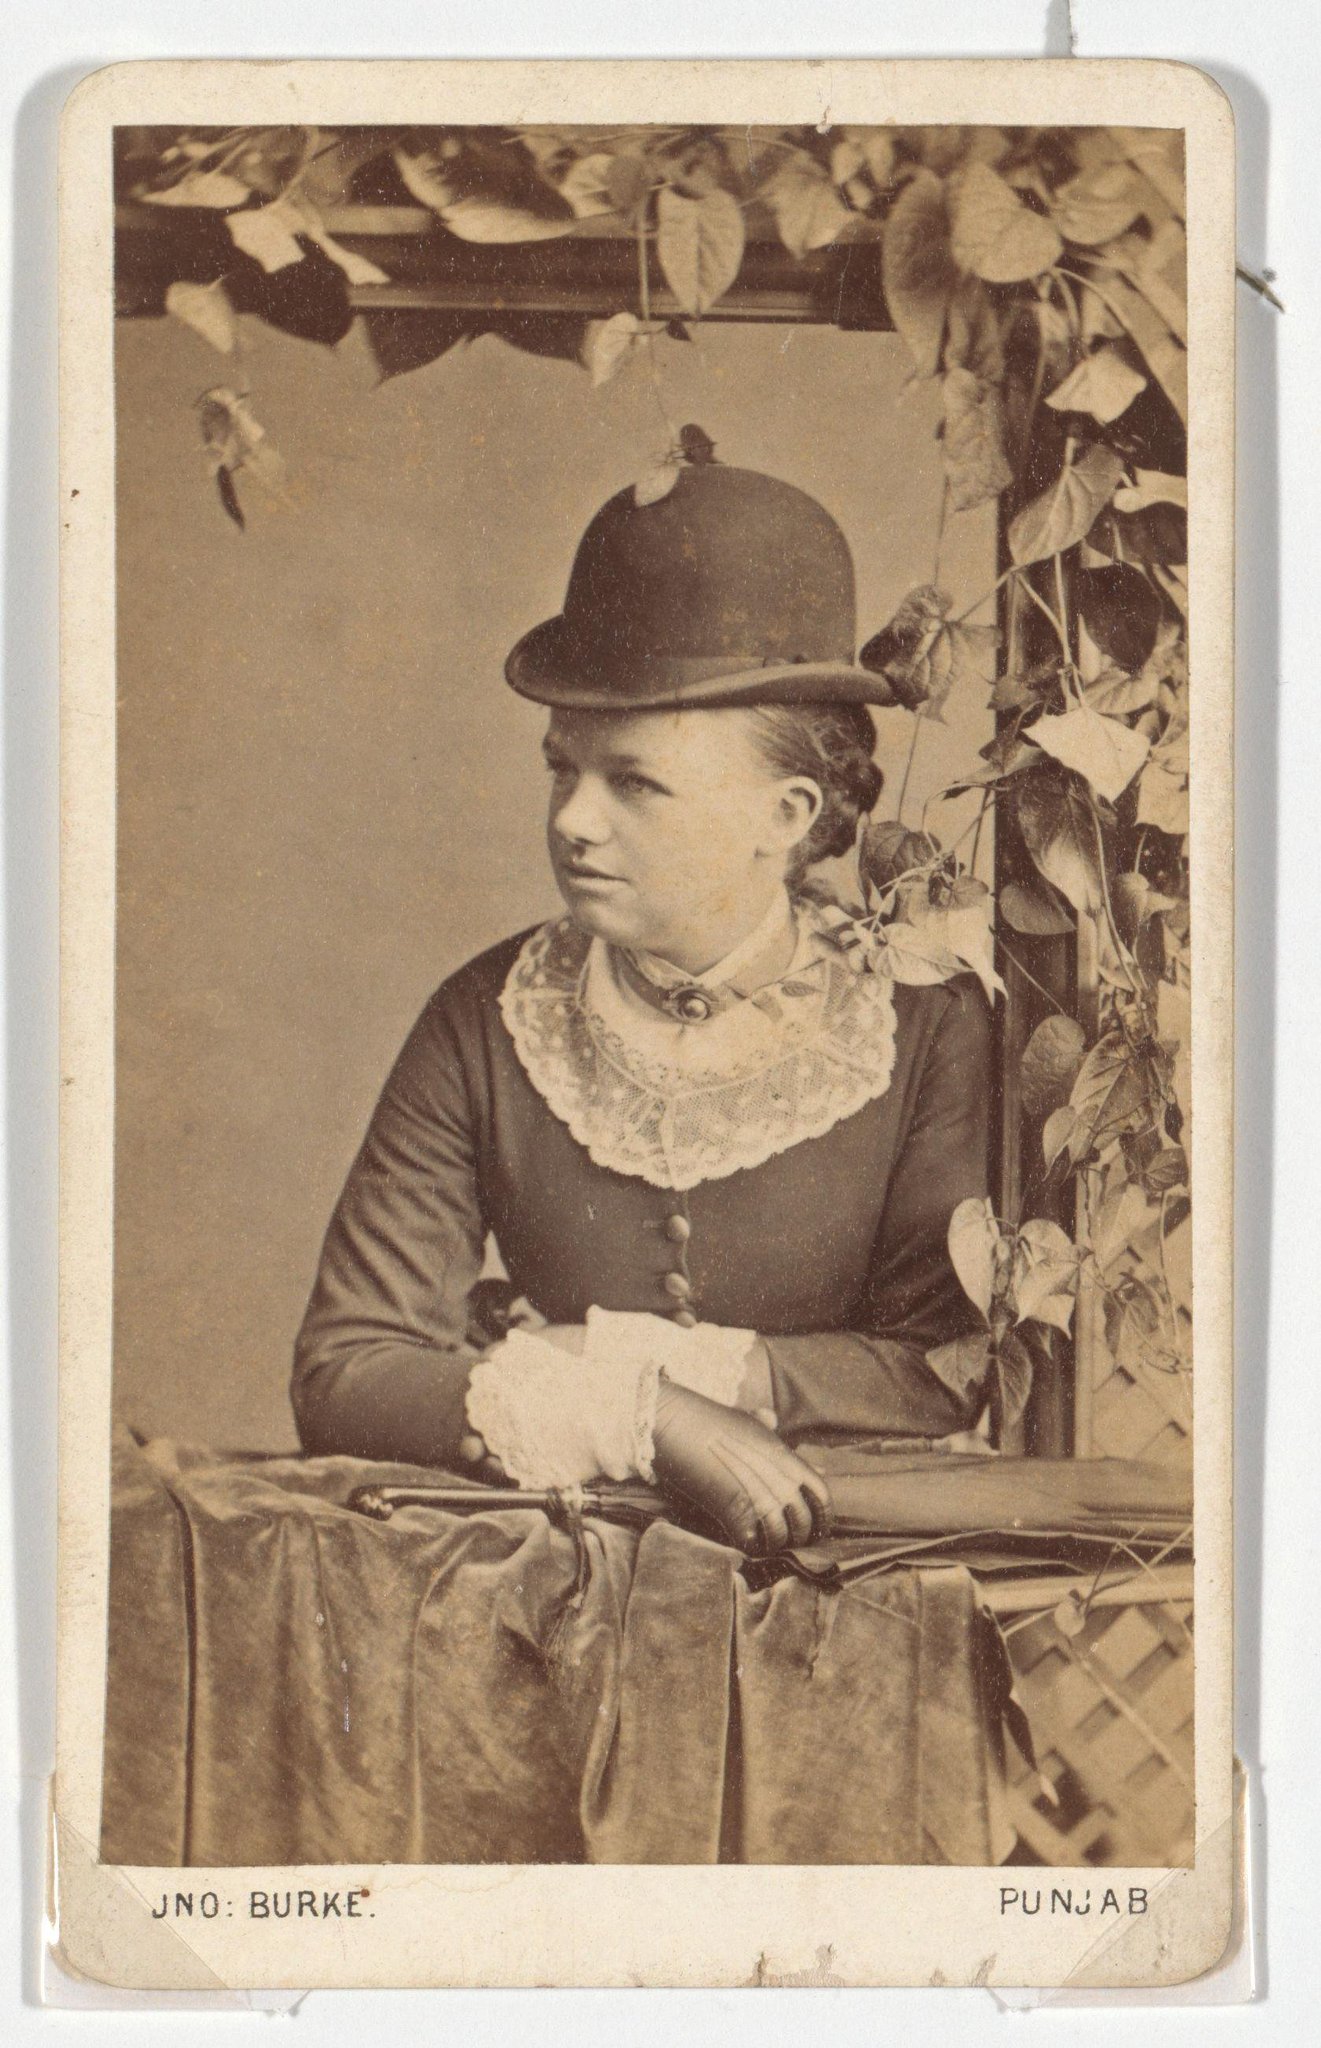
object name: carte de visite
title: Portret van een vrouw met een bolhoed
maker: j.n.o. burke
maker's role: fotograaf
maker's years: 1843-1900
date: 1860-1890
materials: cardboard, paper, photographic support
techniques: albumen print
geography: punjab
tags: studio requisites ~ photographer, head-gear: bowler hat (+ women's clothes), historical persons not known by name - bb - woman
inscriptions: negative number: ‘No. 7409’, name: ‘JNO: Burke, late Baker & Burke Artiste Photographer Punjab’